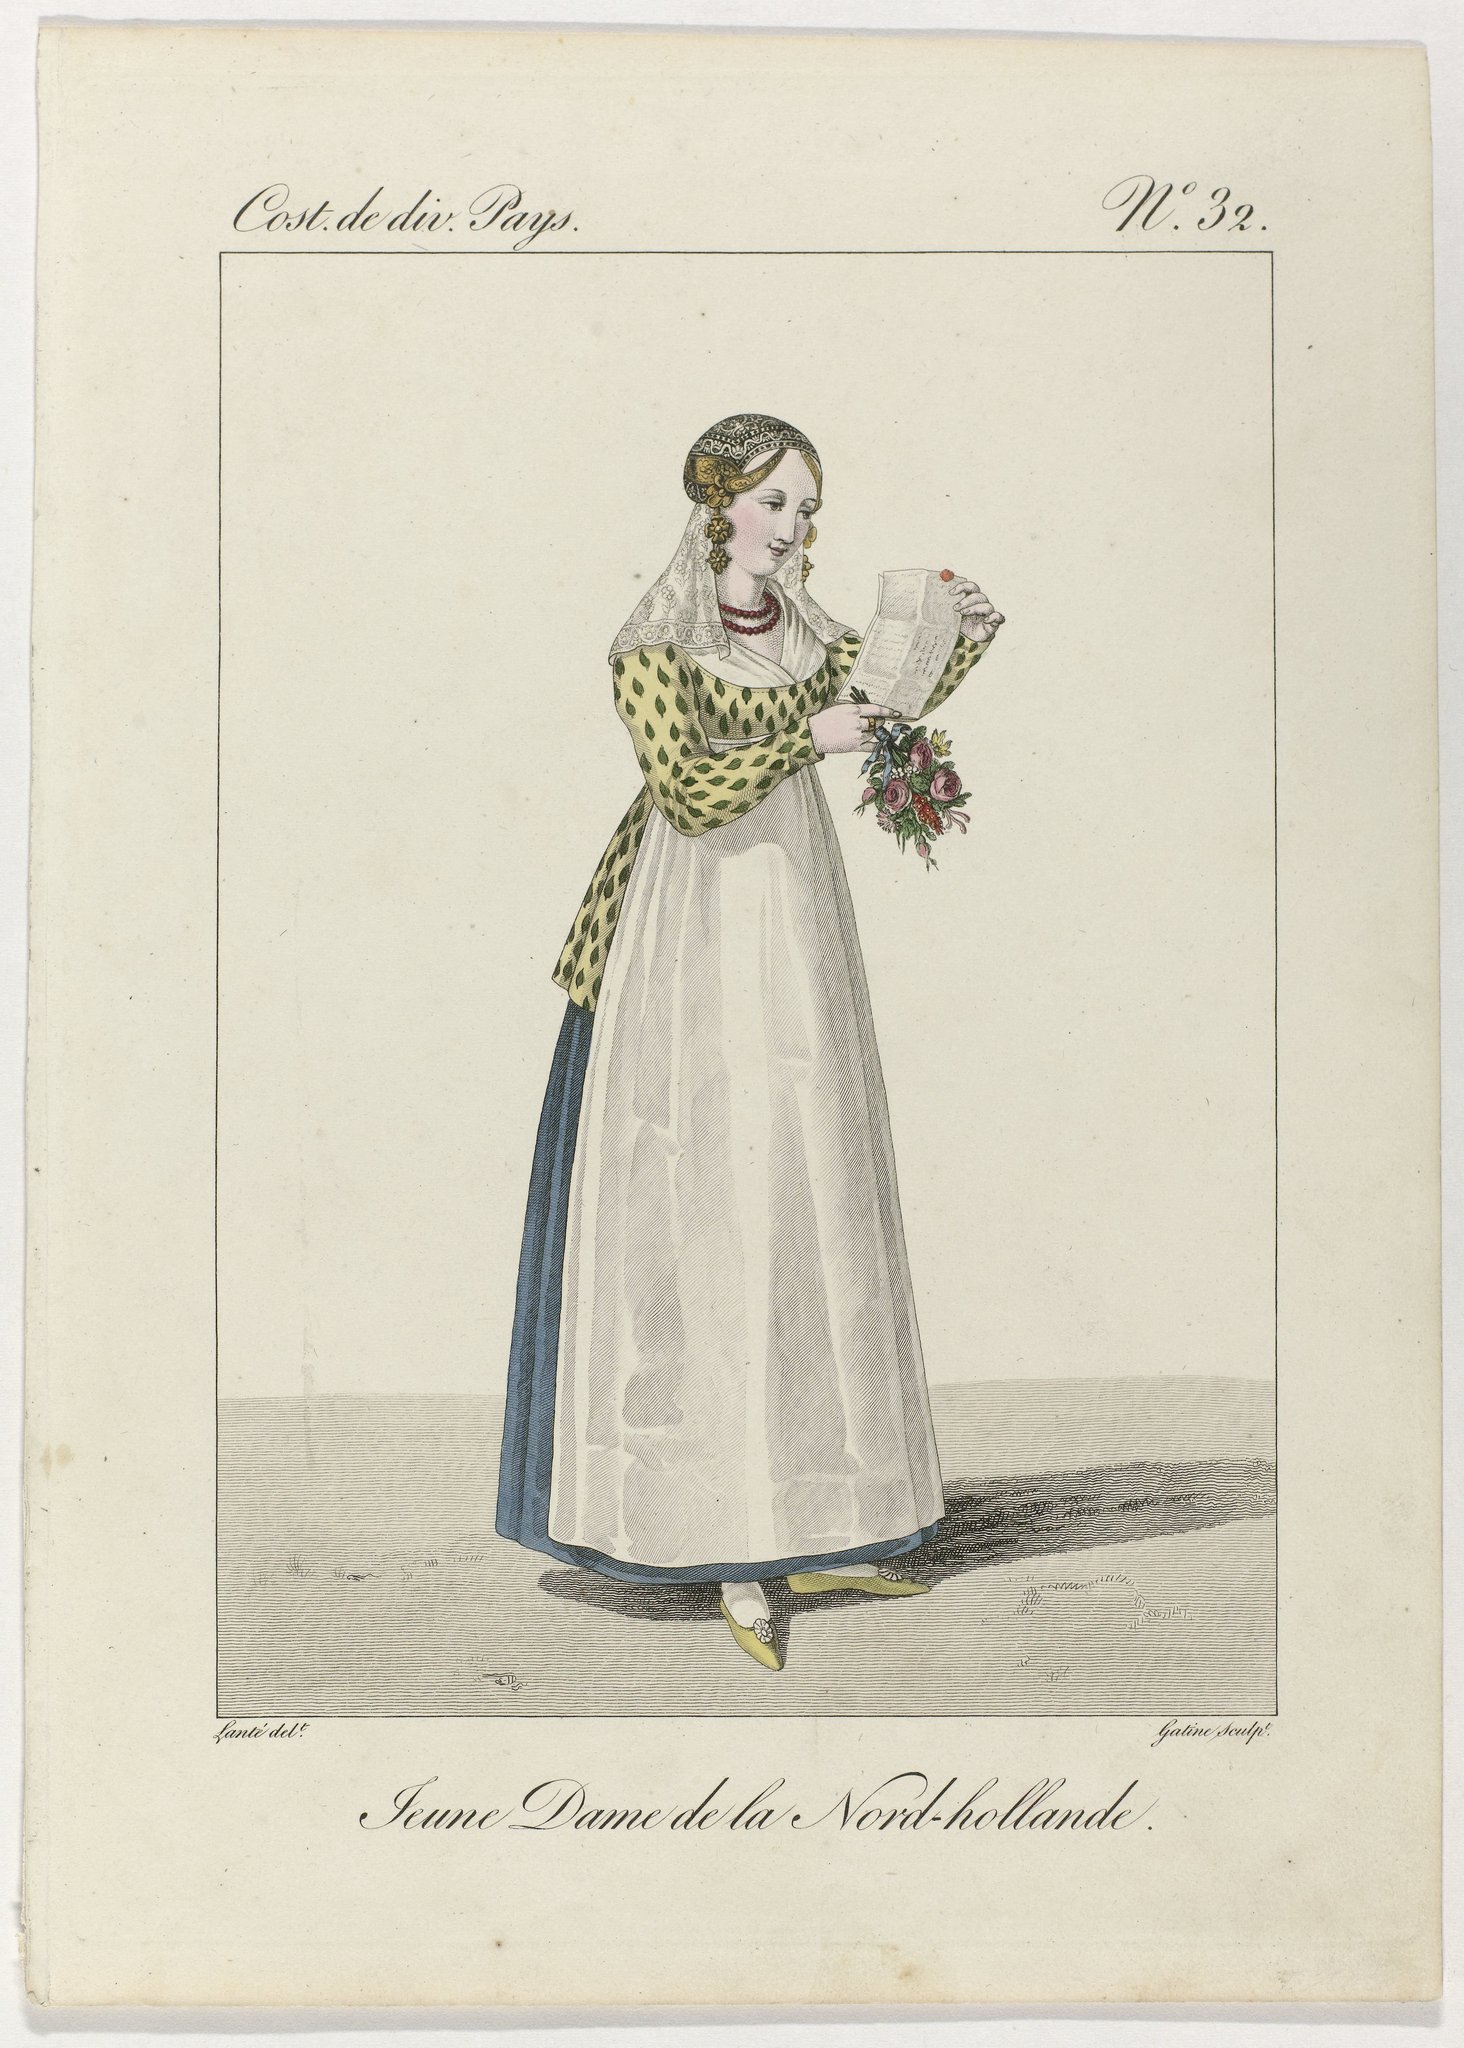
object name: print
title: Costume de divers Pays, 1827, No. 32 : Jeune Dame de la Nord-hollande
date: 1827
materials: paper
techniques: engraving, hand coloring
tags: clothing for the upper part of the body (+ women's clothes), cut flowers; nosegay, bunch of flowers, reading, veil (+ women's clothes), ring (+ women's clothes), folk costume, regional costume, letter, envelope, apron (+ women's clothes), piece of clothing covering the breast or décolleté (fichu) (+ women's clothes), necklace (+ women's clothes)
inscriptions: title: ‘Cost. de div. Pays.’, caption: ‘Jeune Dame de la Nord-hollande.’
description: Jonge vrouw in klederdracht uit Noord-Holland. Zij leest een brief.